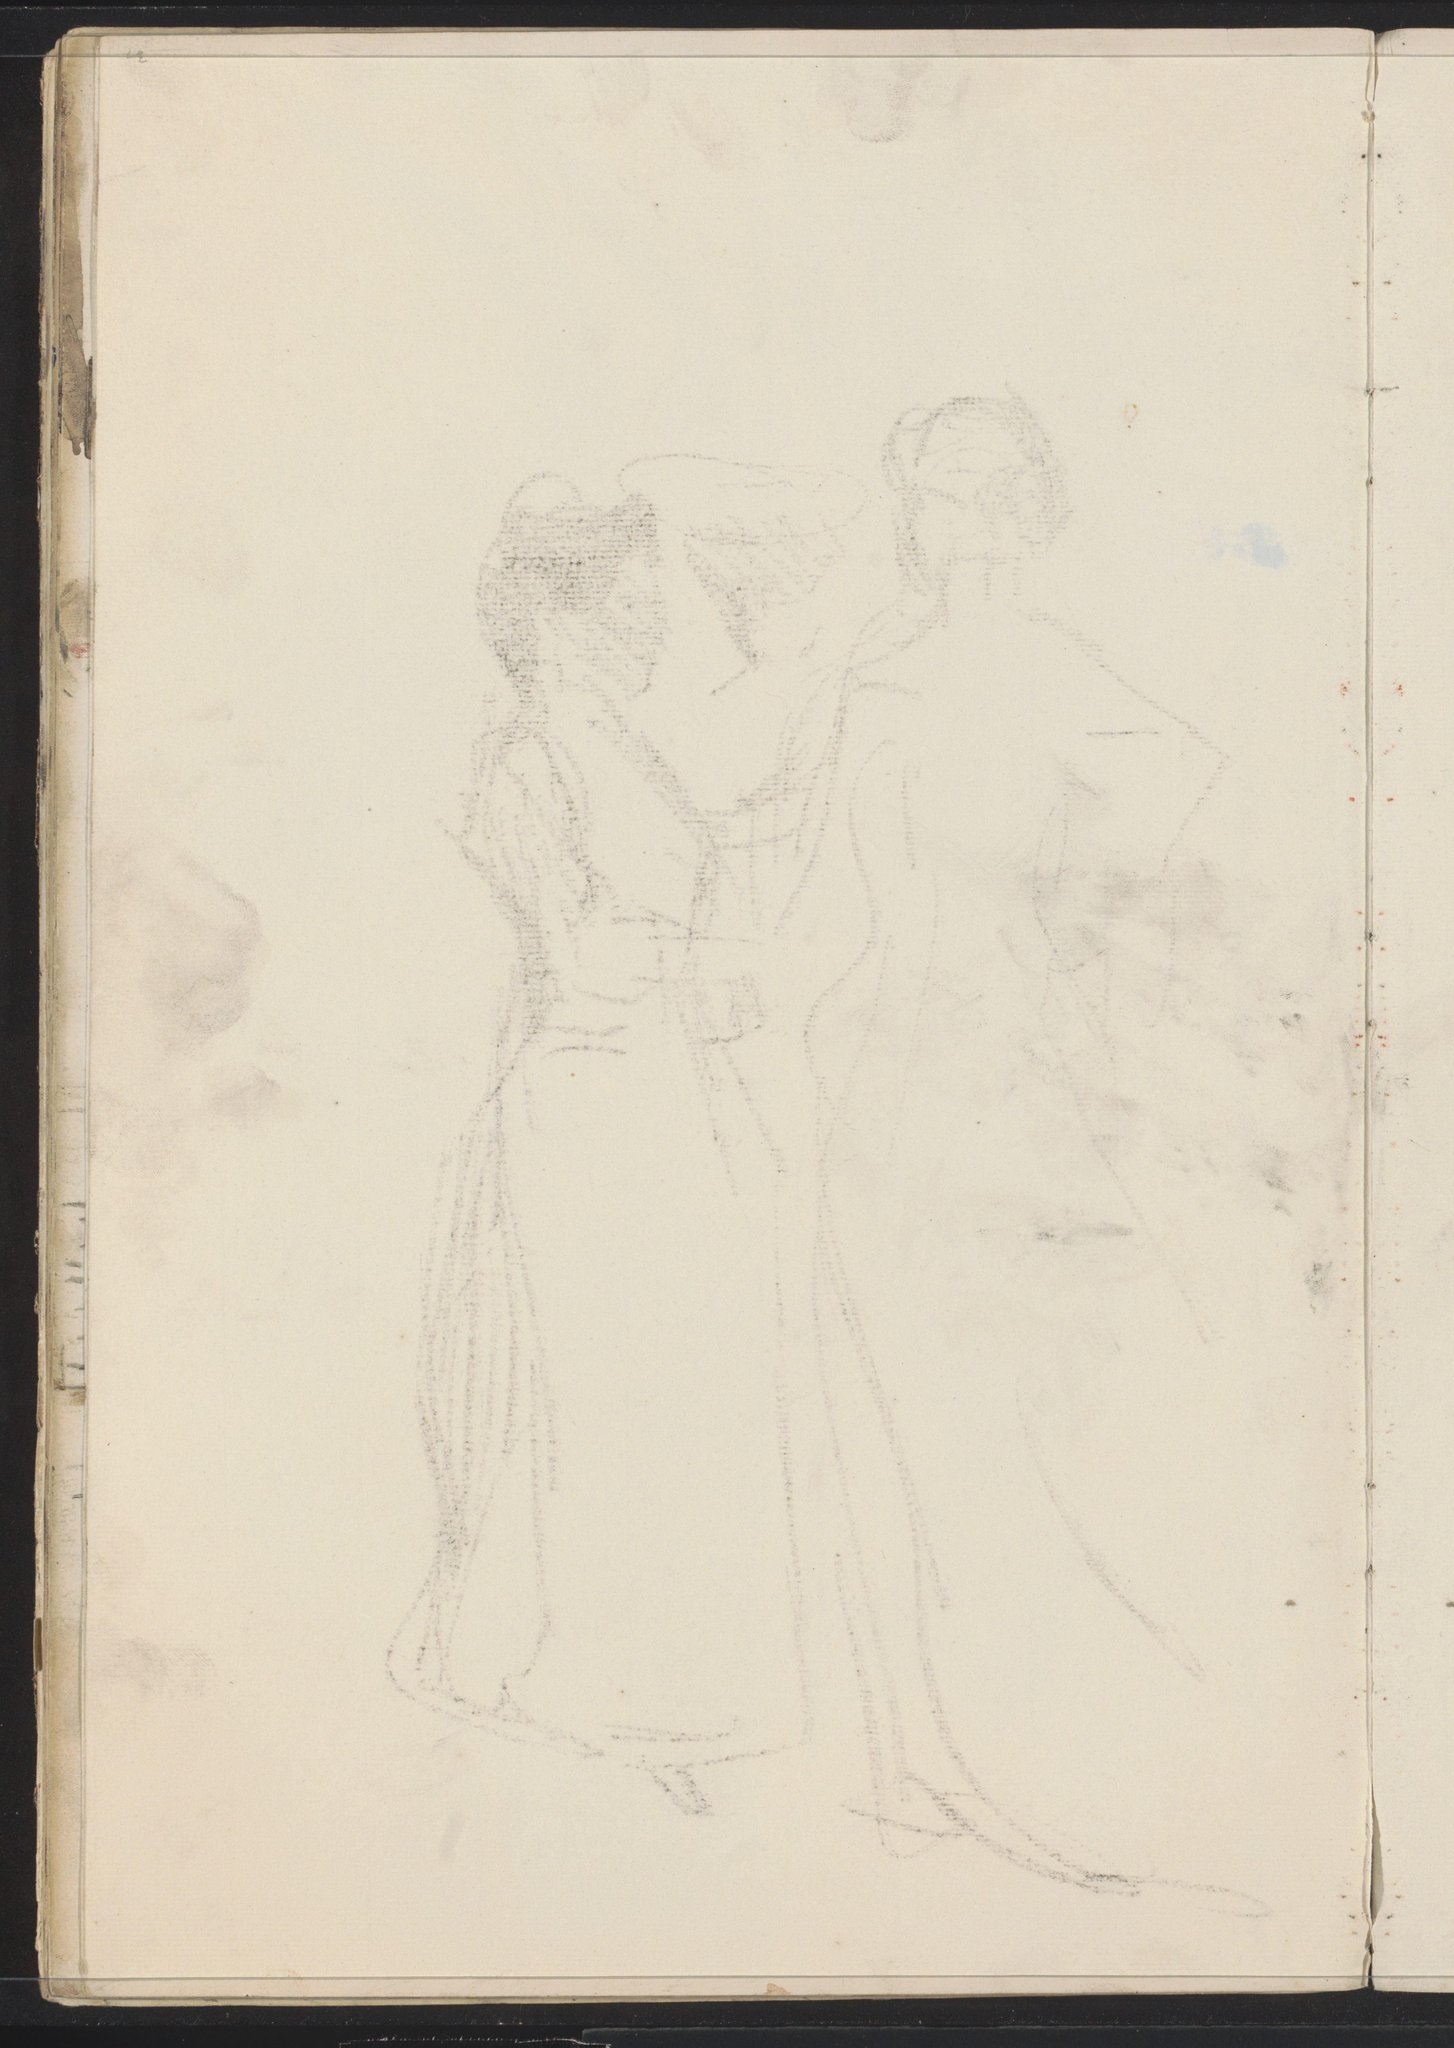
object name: sketchbook leaf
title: Abklatsch van de krijttekening op blad 21 recto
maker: isaac israels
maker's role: draughtsman, painter, print maker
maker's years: 1865-1934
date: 1875-1934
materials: paper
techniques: printmaking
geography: the hague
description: Blad 20 verso uit schetsboek LXIX met 25 bladen.